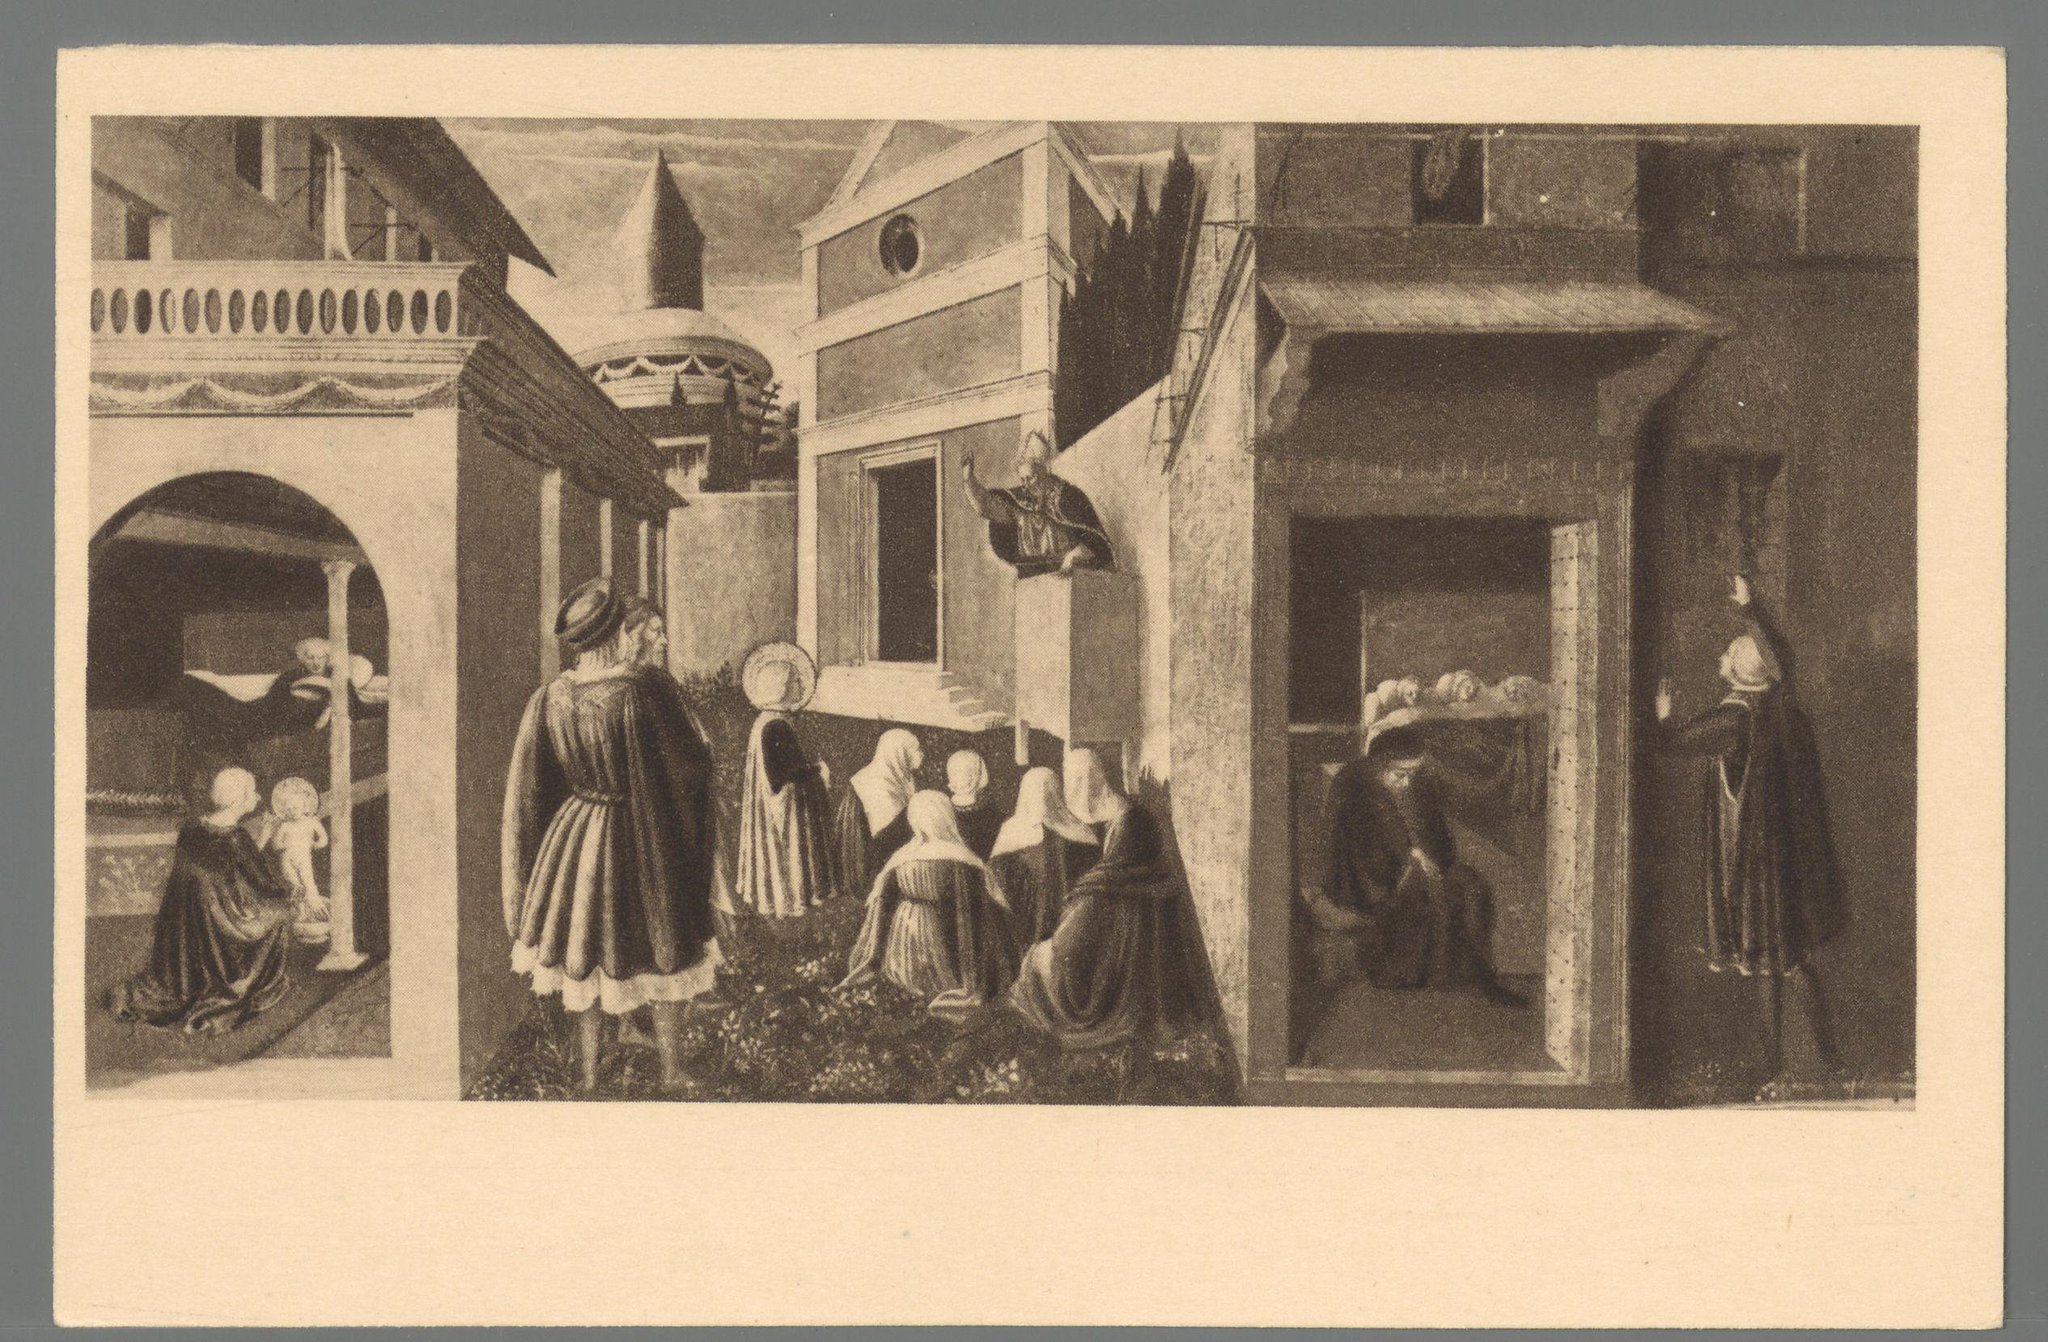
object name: photomechanical print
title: Fra Angelico (1378-1455). De H. Nicolaas staat terstond na zijn geboorte - luistert naar cen preck - werpt een bruidsschat door het venster - Rome, Pinacoteca Vaticana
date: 1928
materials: cardboard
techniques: rotogravure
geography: milan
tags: permanent exhibition, museum, picture, painting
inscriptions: collector's mark: ‘AFE v S’